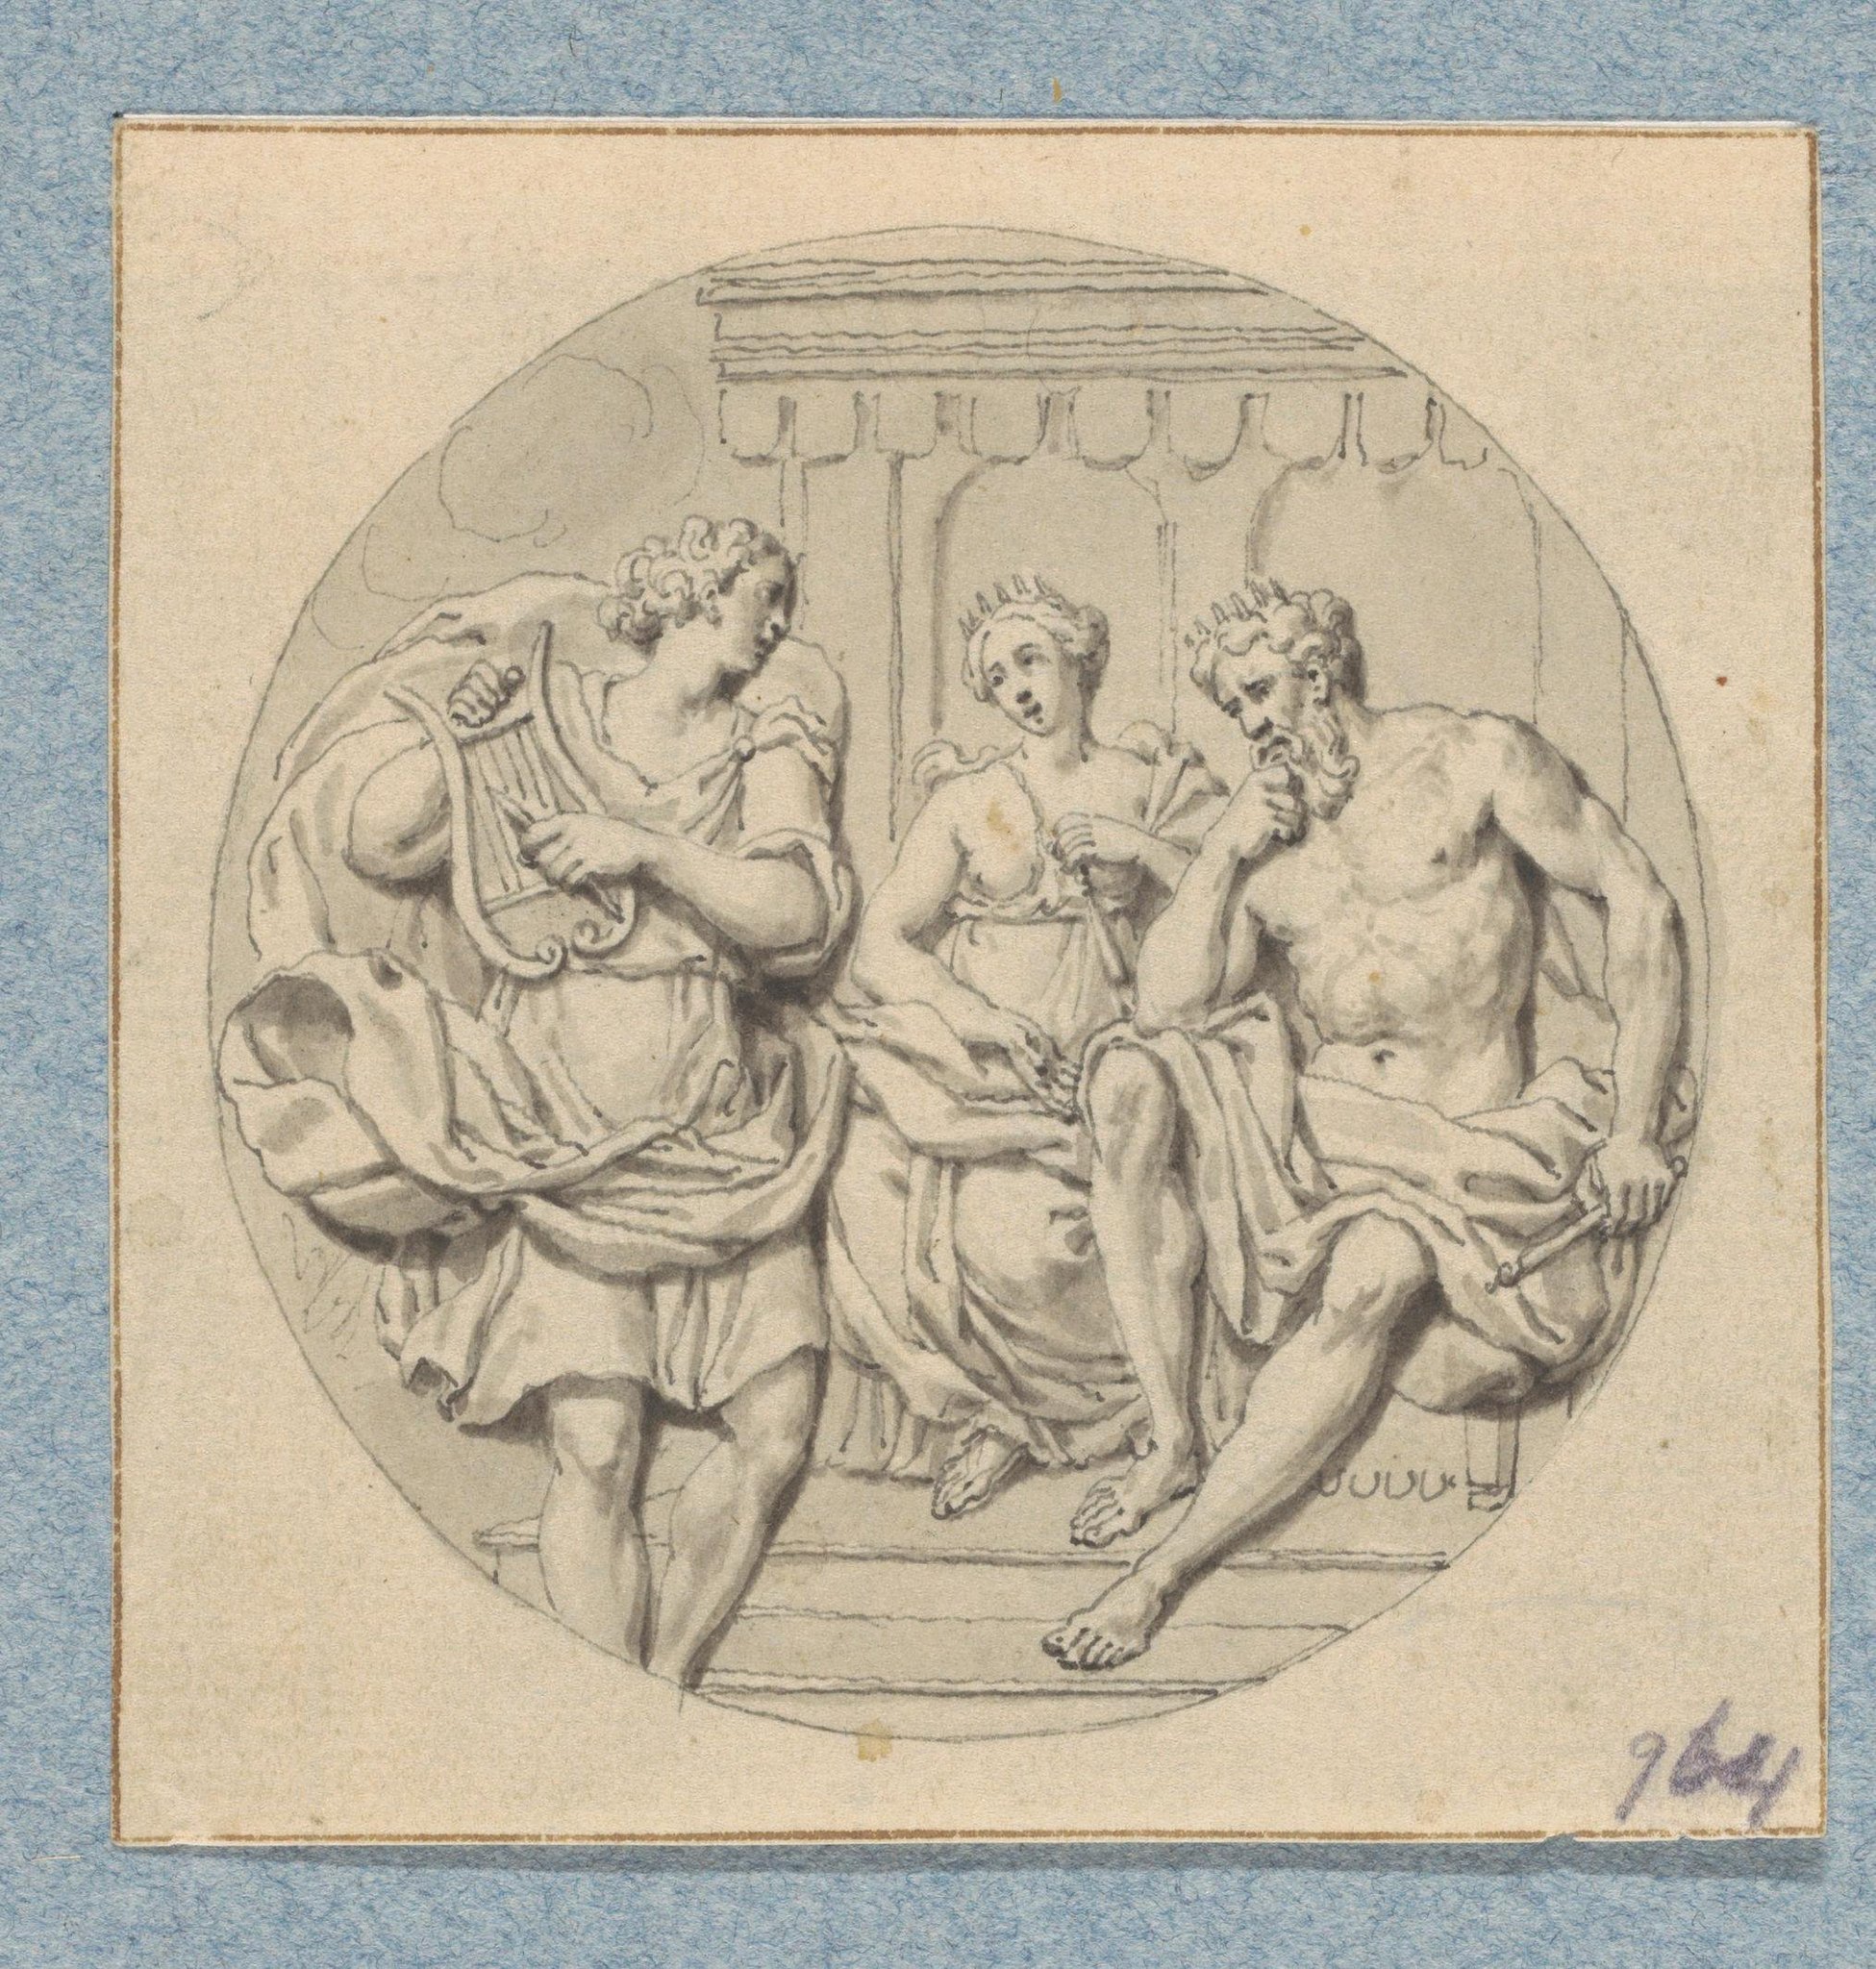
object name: drawing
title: Orpheus speelt voor Pluto en Proserpina (in doos met 43 tekeningen)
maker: louis fabritius dubourg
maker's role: draughtsman, print maker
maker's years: 1693-1775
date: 1703-1775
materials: ink, paper, pencil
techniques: brush, pen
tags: pluto and proserpina as king and queen of the underworld, non-aggressive, friendly or neutral activities and relationships of orpheus